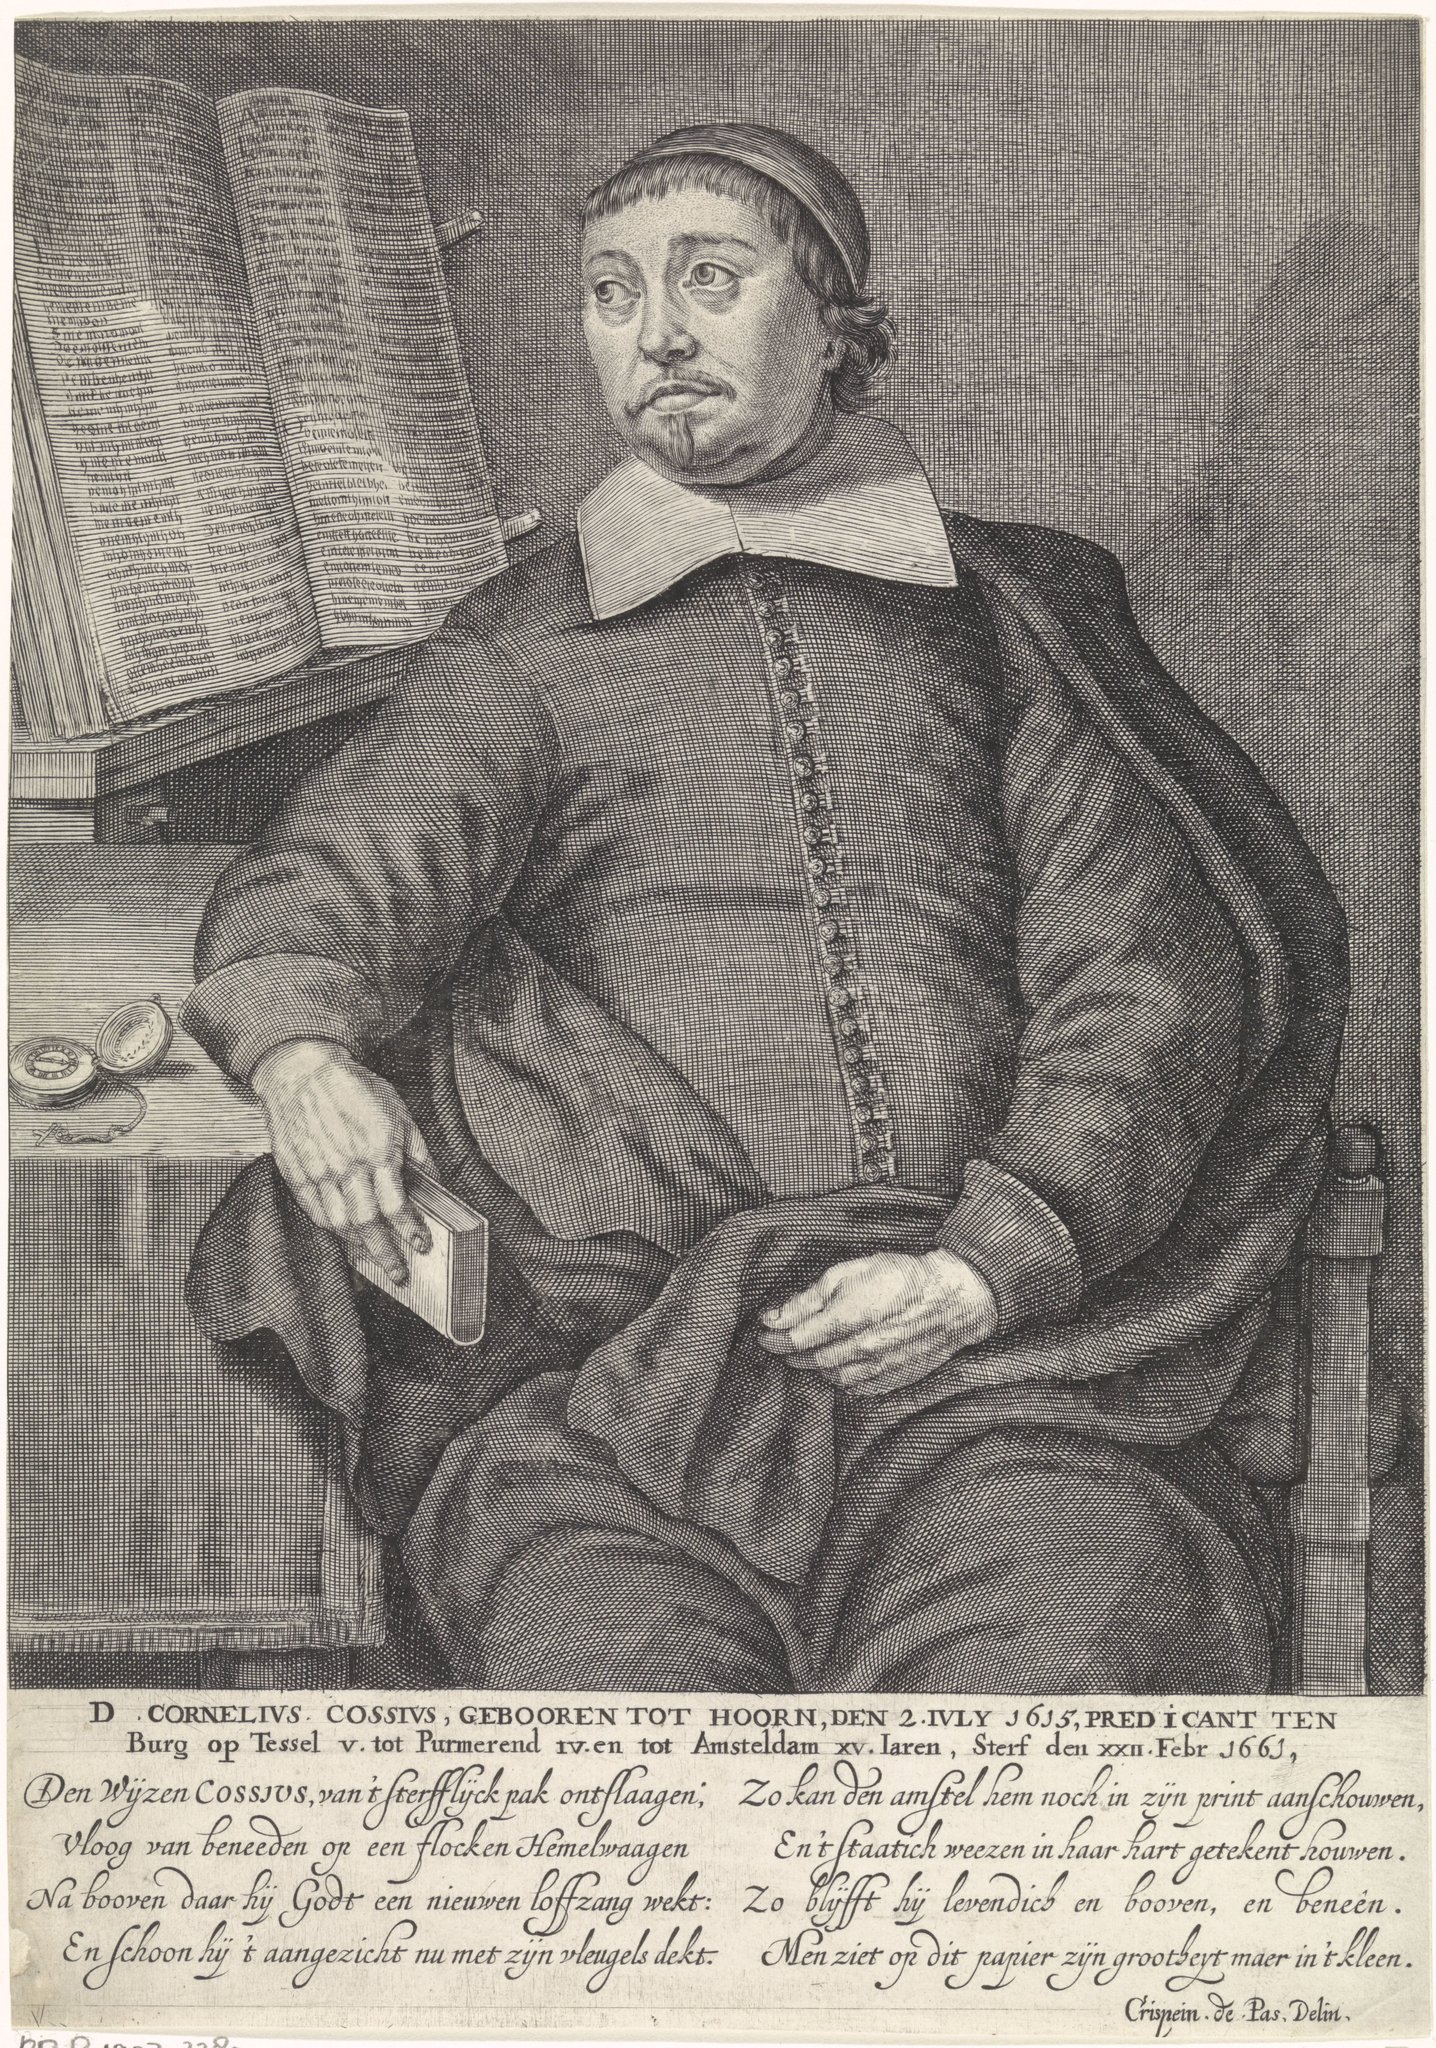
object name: print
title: Portret van Cornelius Cossius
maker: crispijn van de passe (ii)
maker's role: draughtsman, print maker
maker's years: 1594-1670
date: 1661-1670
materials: paper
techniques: engraving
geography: northern netherlands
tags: hoorn (north holland)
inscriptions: collector's mark: Lugt 2228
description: Portret van de predikant Cornelius Cossius. In de marge een achtregelig lofdicht, in twee kolommen, in het Nederlands.